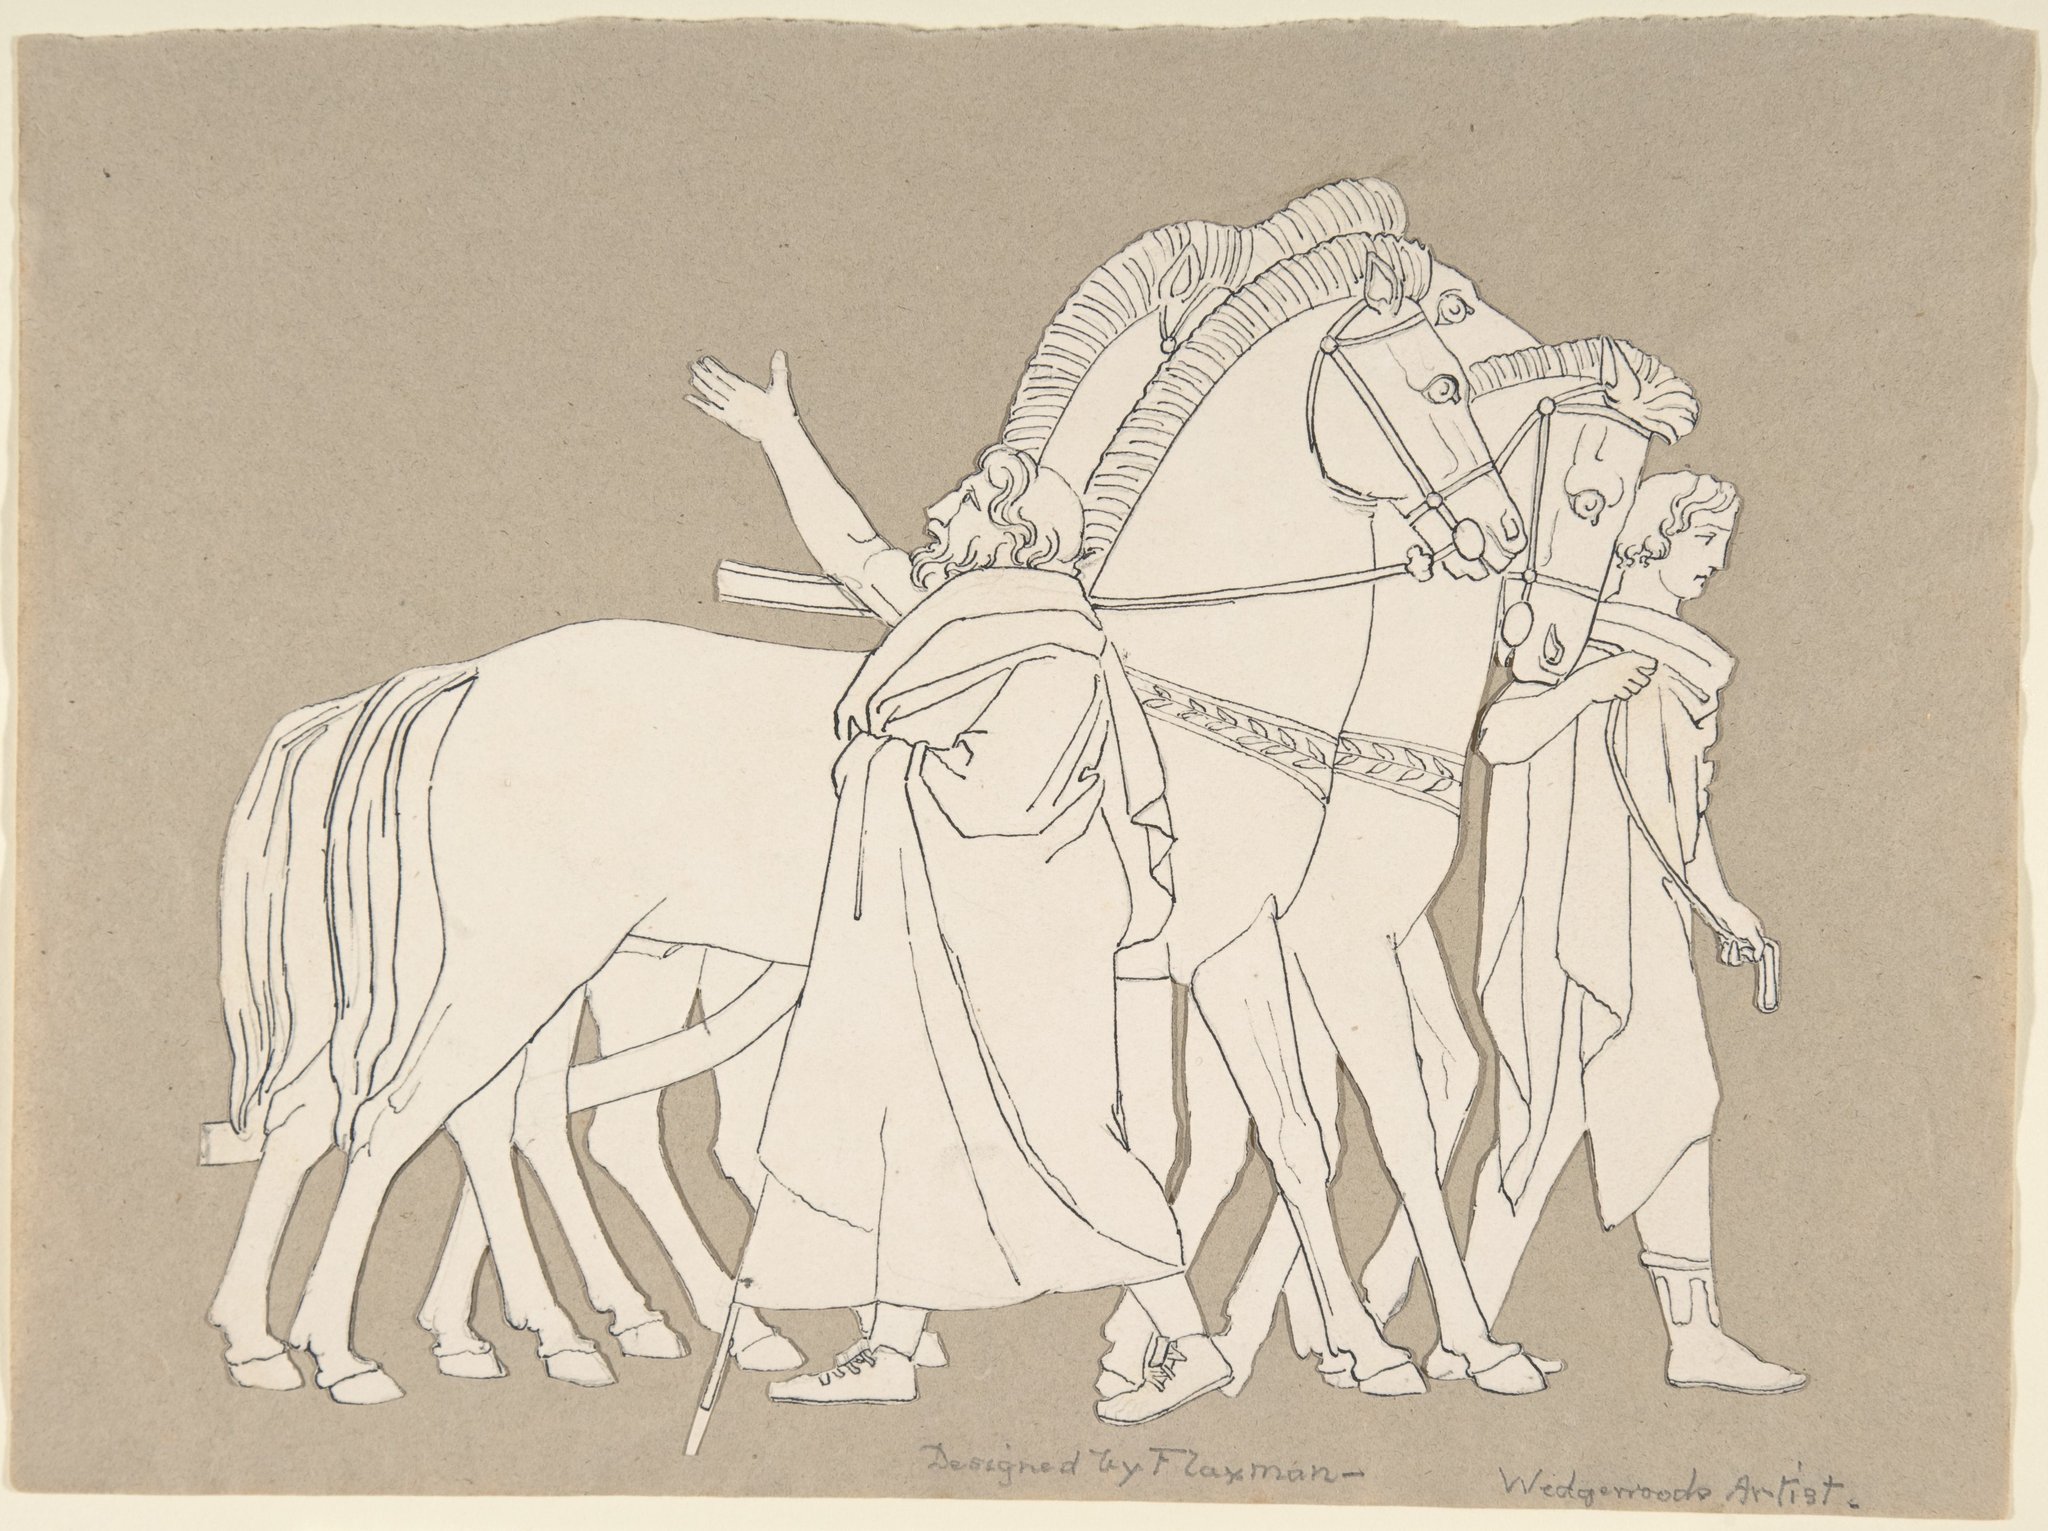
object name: drawing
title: Two male classical figures with three horses (design for large fireplace white tiles produced in Wedgwood's factory)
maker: john flaxman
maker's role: artist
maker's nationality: british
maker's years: 1755-1826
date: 1801-1900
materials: graphite, ink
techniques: pen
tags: men,horses